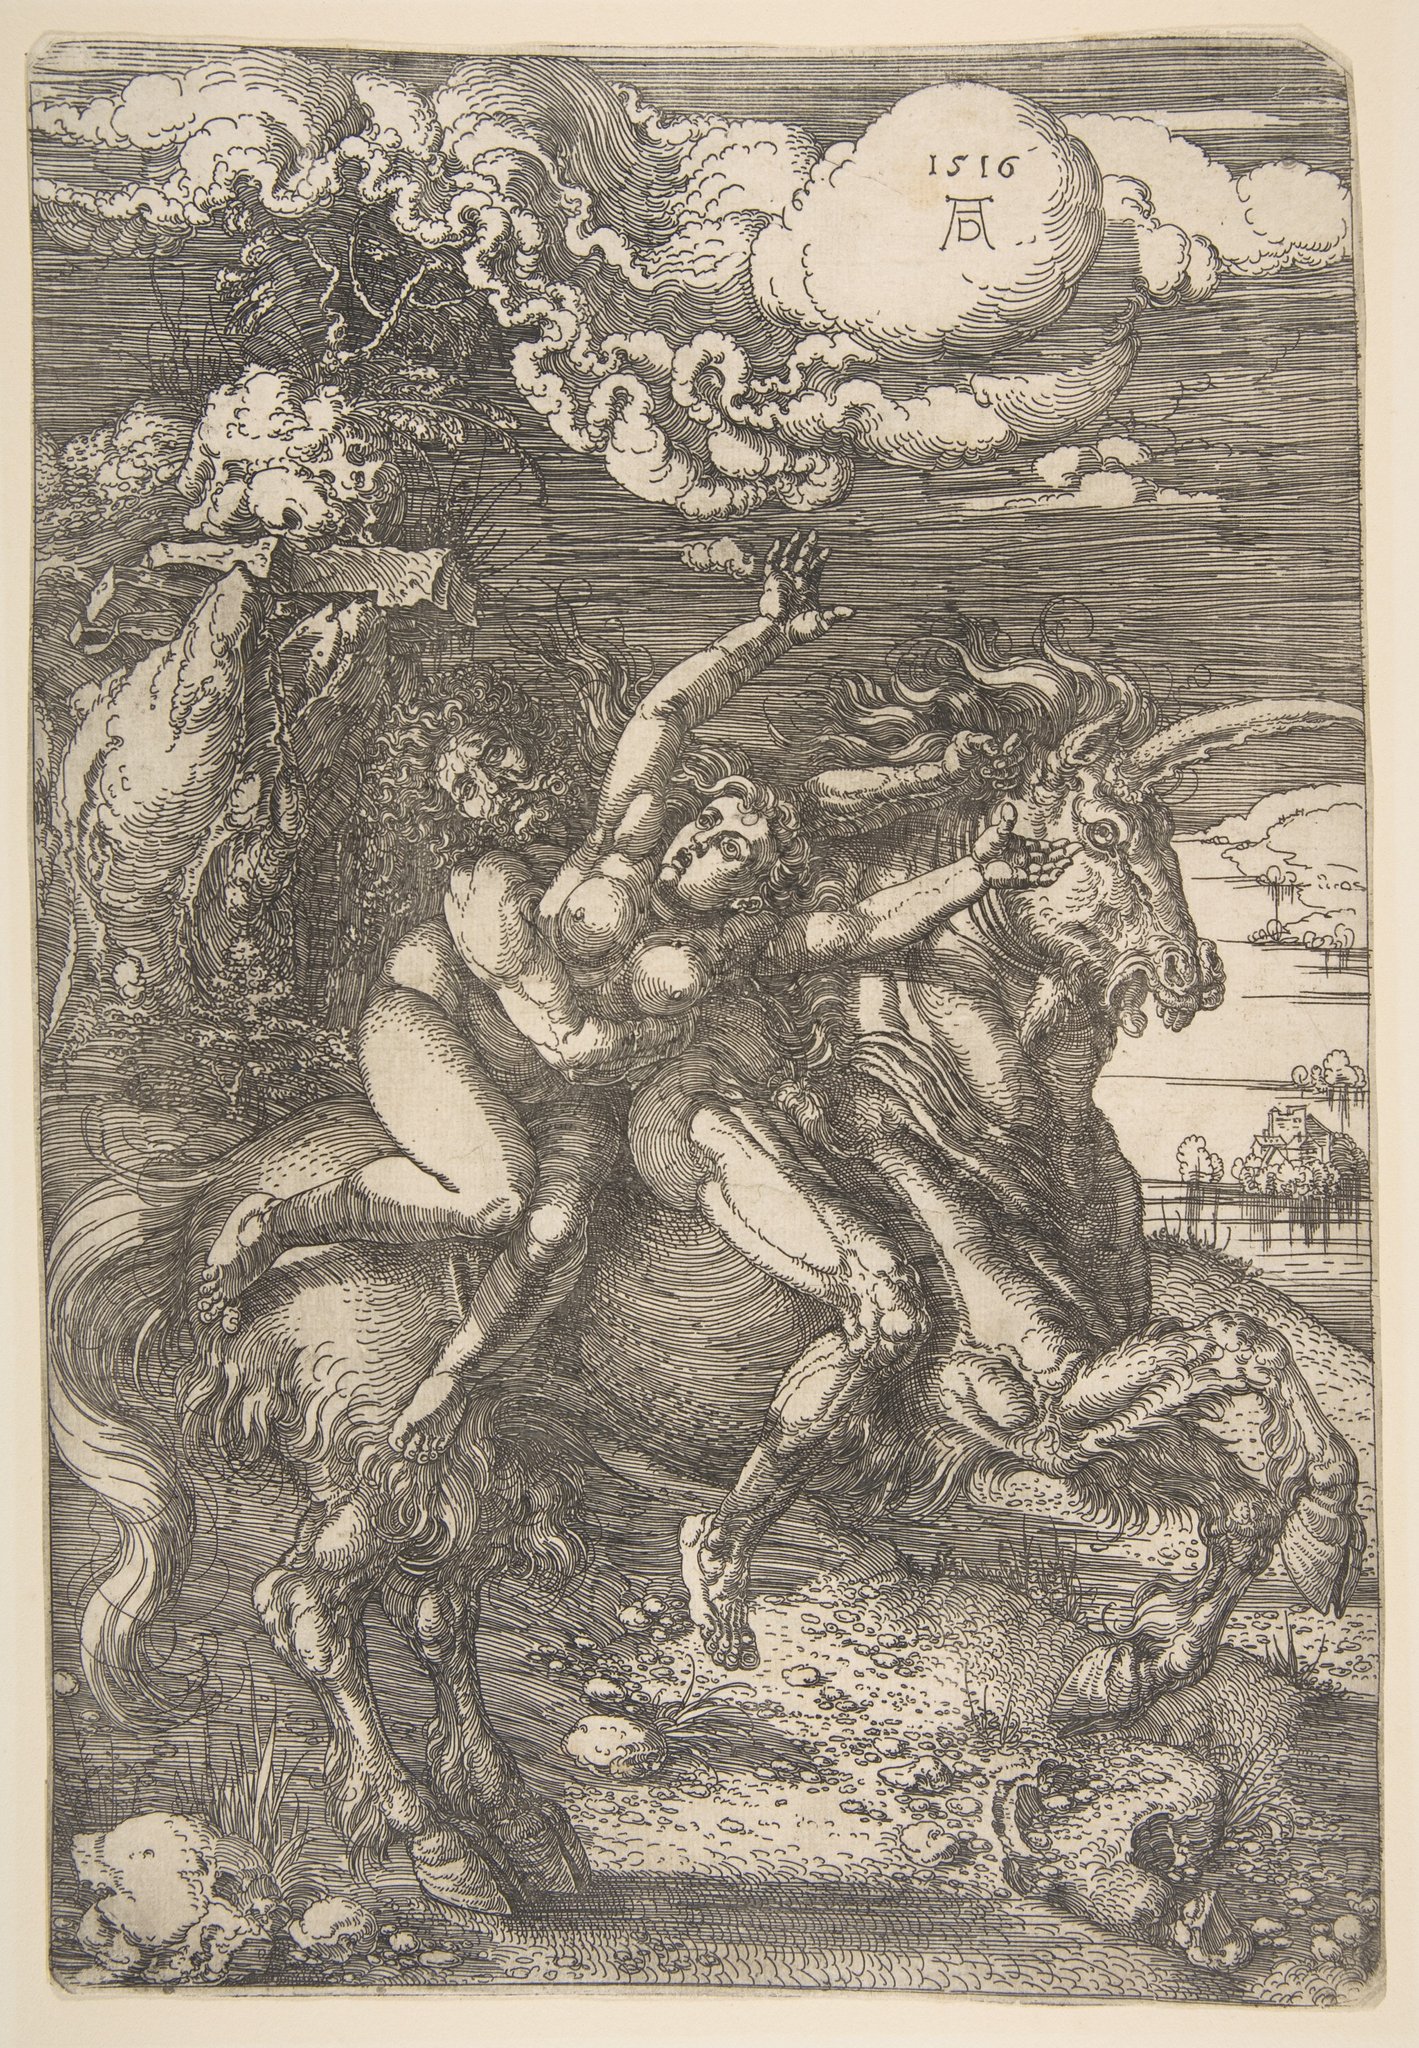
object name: print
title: Abduction of Proserpine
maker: albrecht dürer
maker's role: artist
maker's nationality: german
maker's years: 1471-1528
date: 1516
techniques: etching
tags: men,horses,goddess